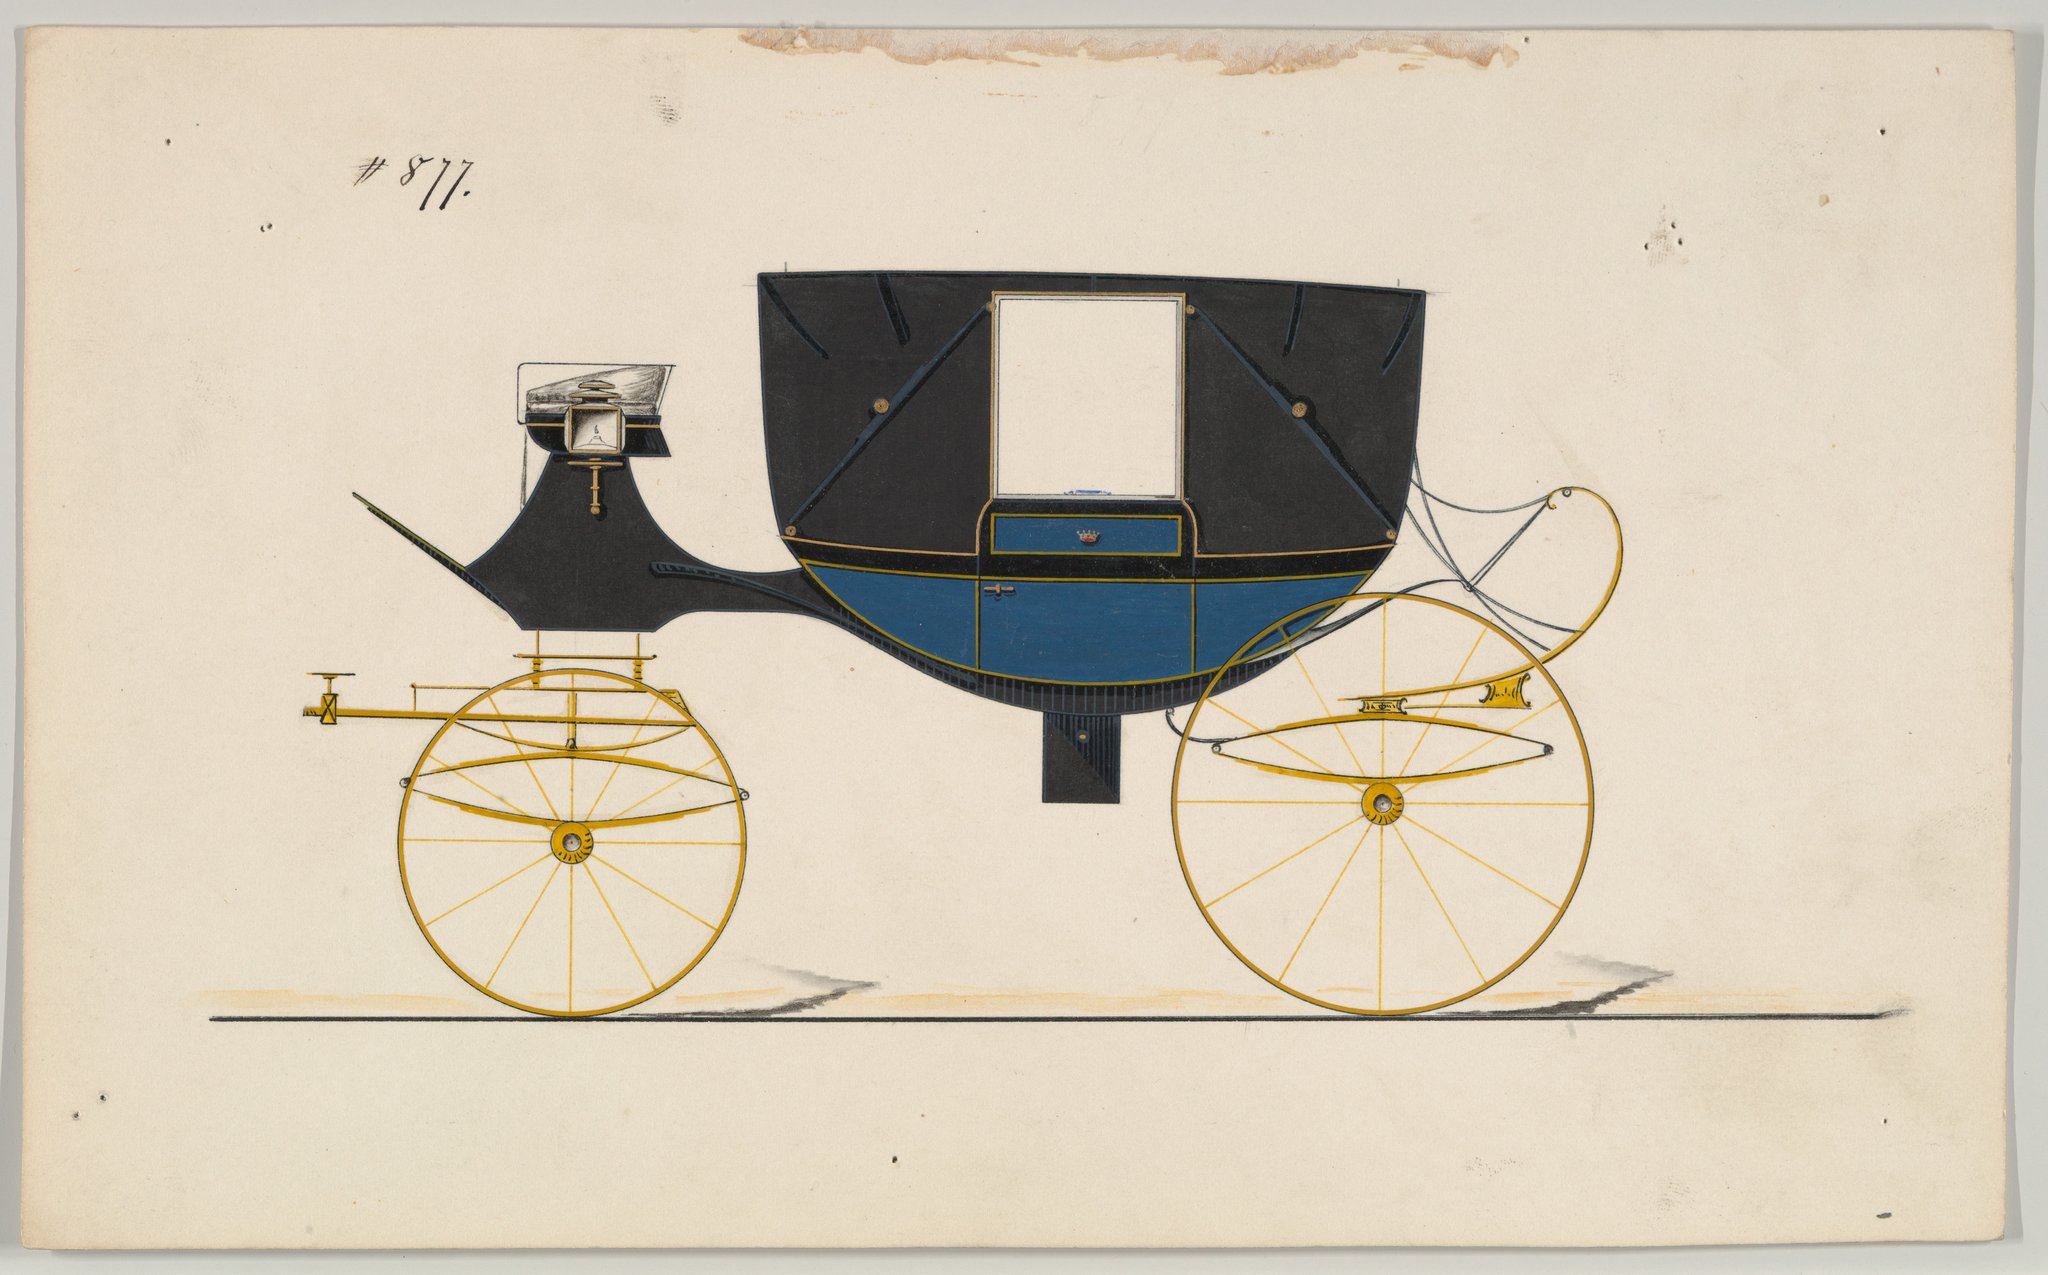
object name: drawing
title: Landau #877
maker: brewster & co.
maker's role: manufacturer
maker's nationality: american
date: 1851-1900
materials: gouache, gum arabic, ink, watercolor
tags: carriages